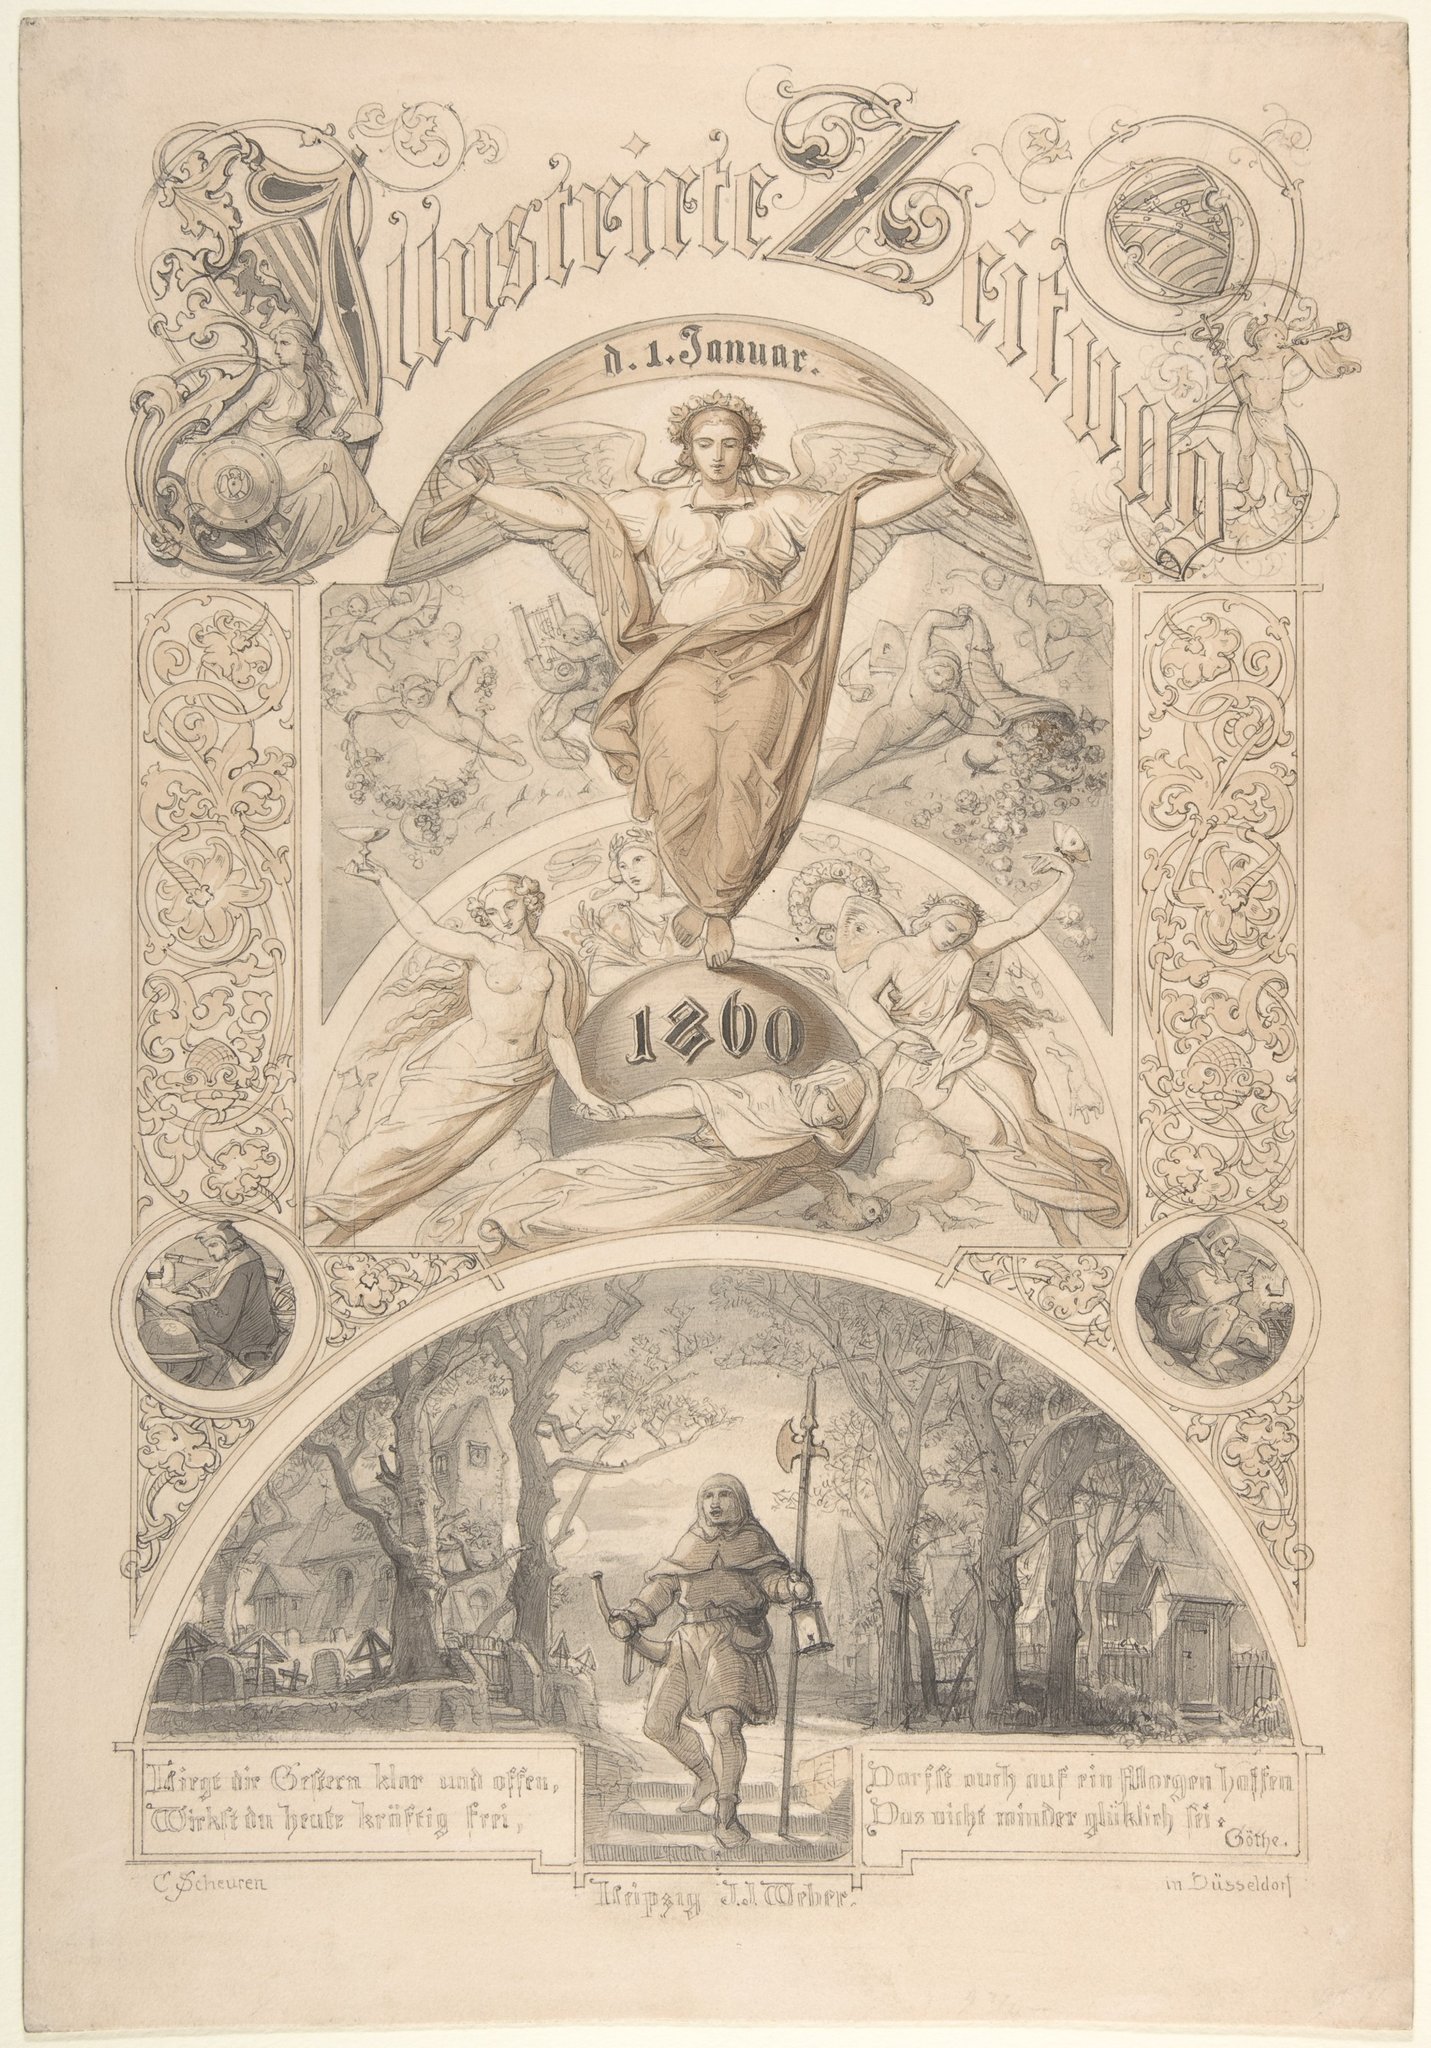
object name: drawing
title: Cover design for the "Illustrirte Zeitung"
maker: caspar johann nepomuk scheuren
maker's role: artist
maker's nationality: german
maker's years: 1810-1887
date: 1860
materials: graphite, ink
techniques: brush, pen, wash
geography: germany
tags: men,women